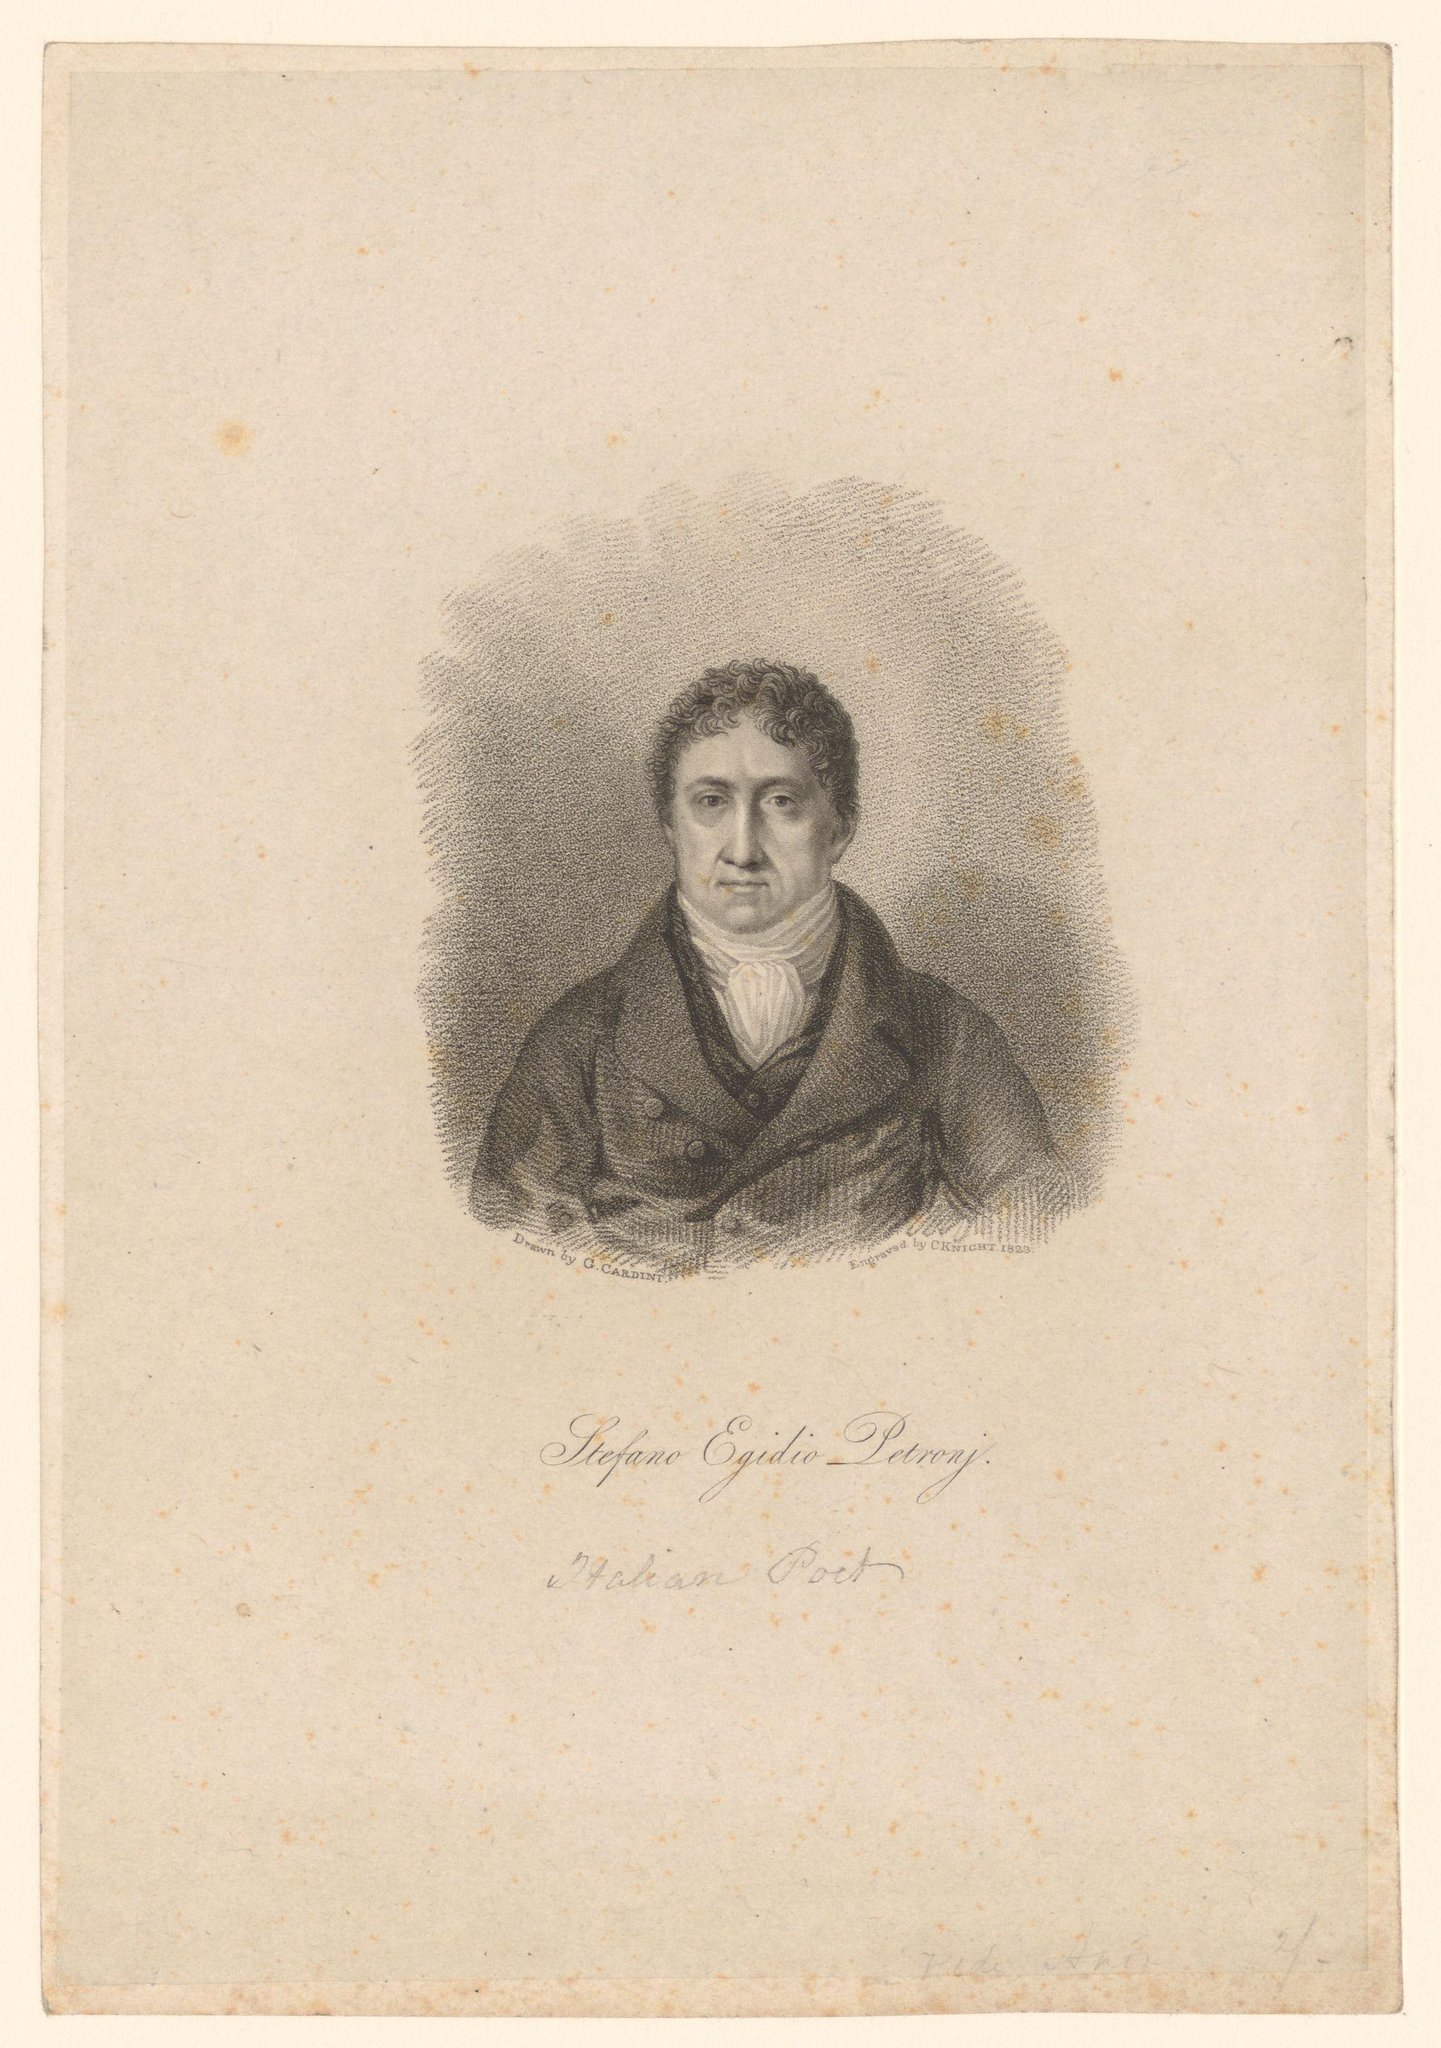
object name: print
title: Portret van Stefano Egidio Petronj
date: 1823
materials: paper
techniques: printmaking, etching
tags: historical persons, writer, poet, author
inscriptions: collector's mark: Lugt 2228